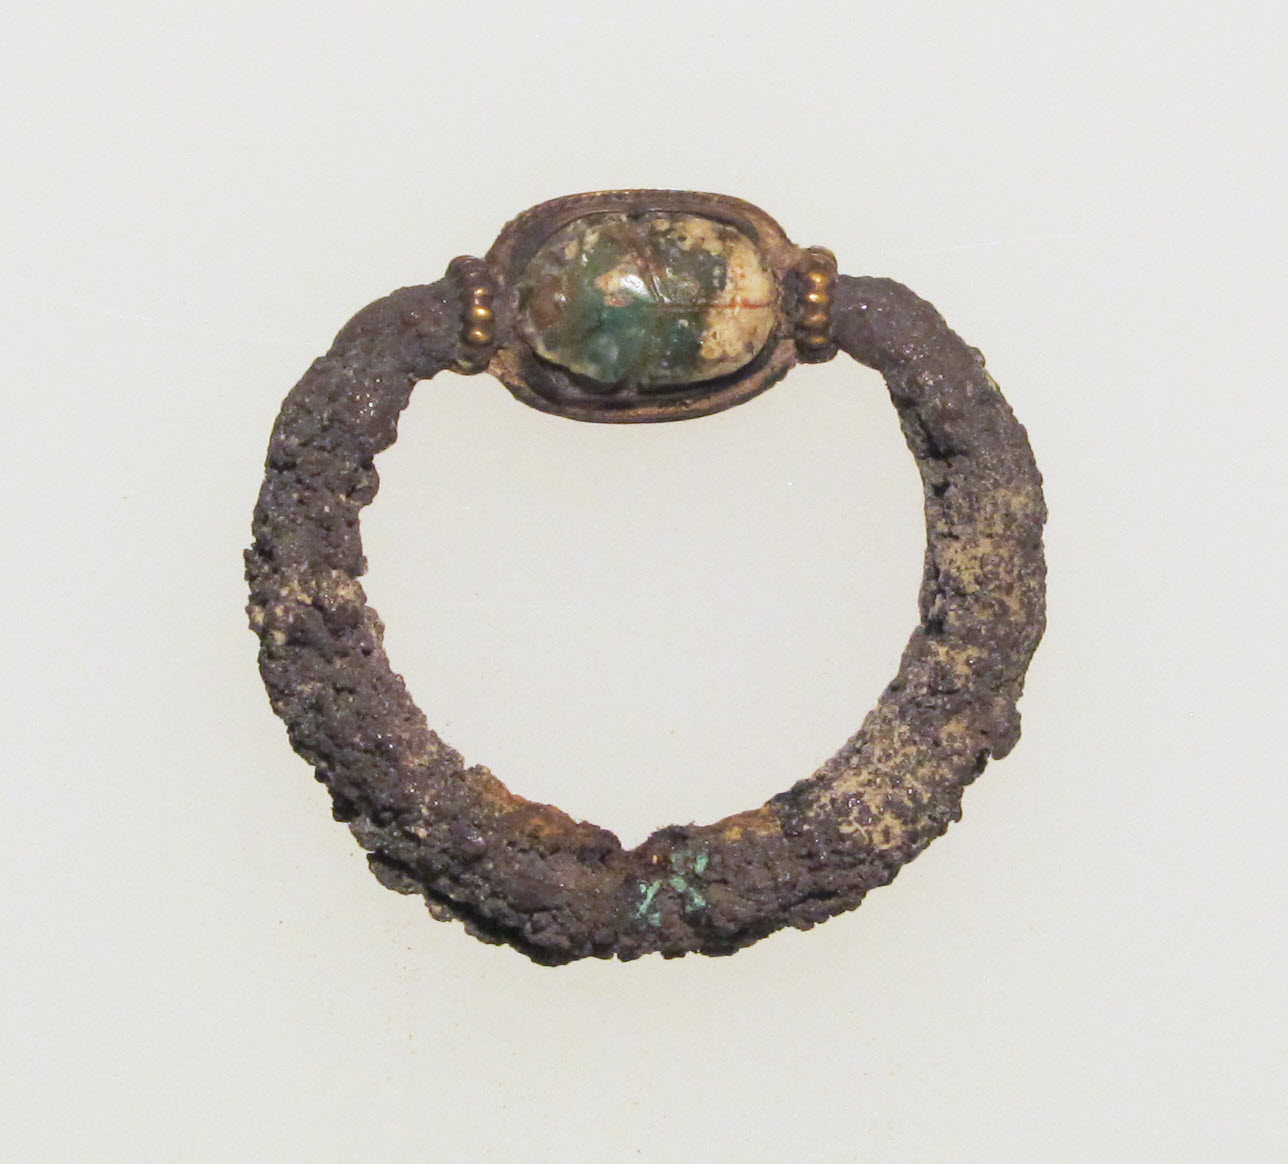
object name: ring with scarab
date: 7000 BCE-330 CE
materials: silver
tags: scarabs